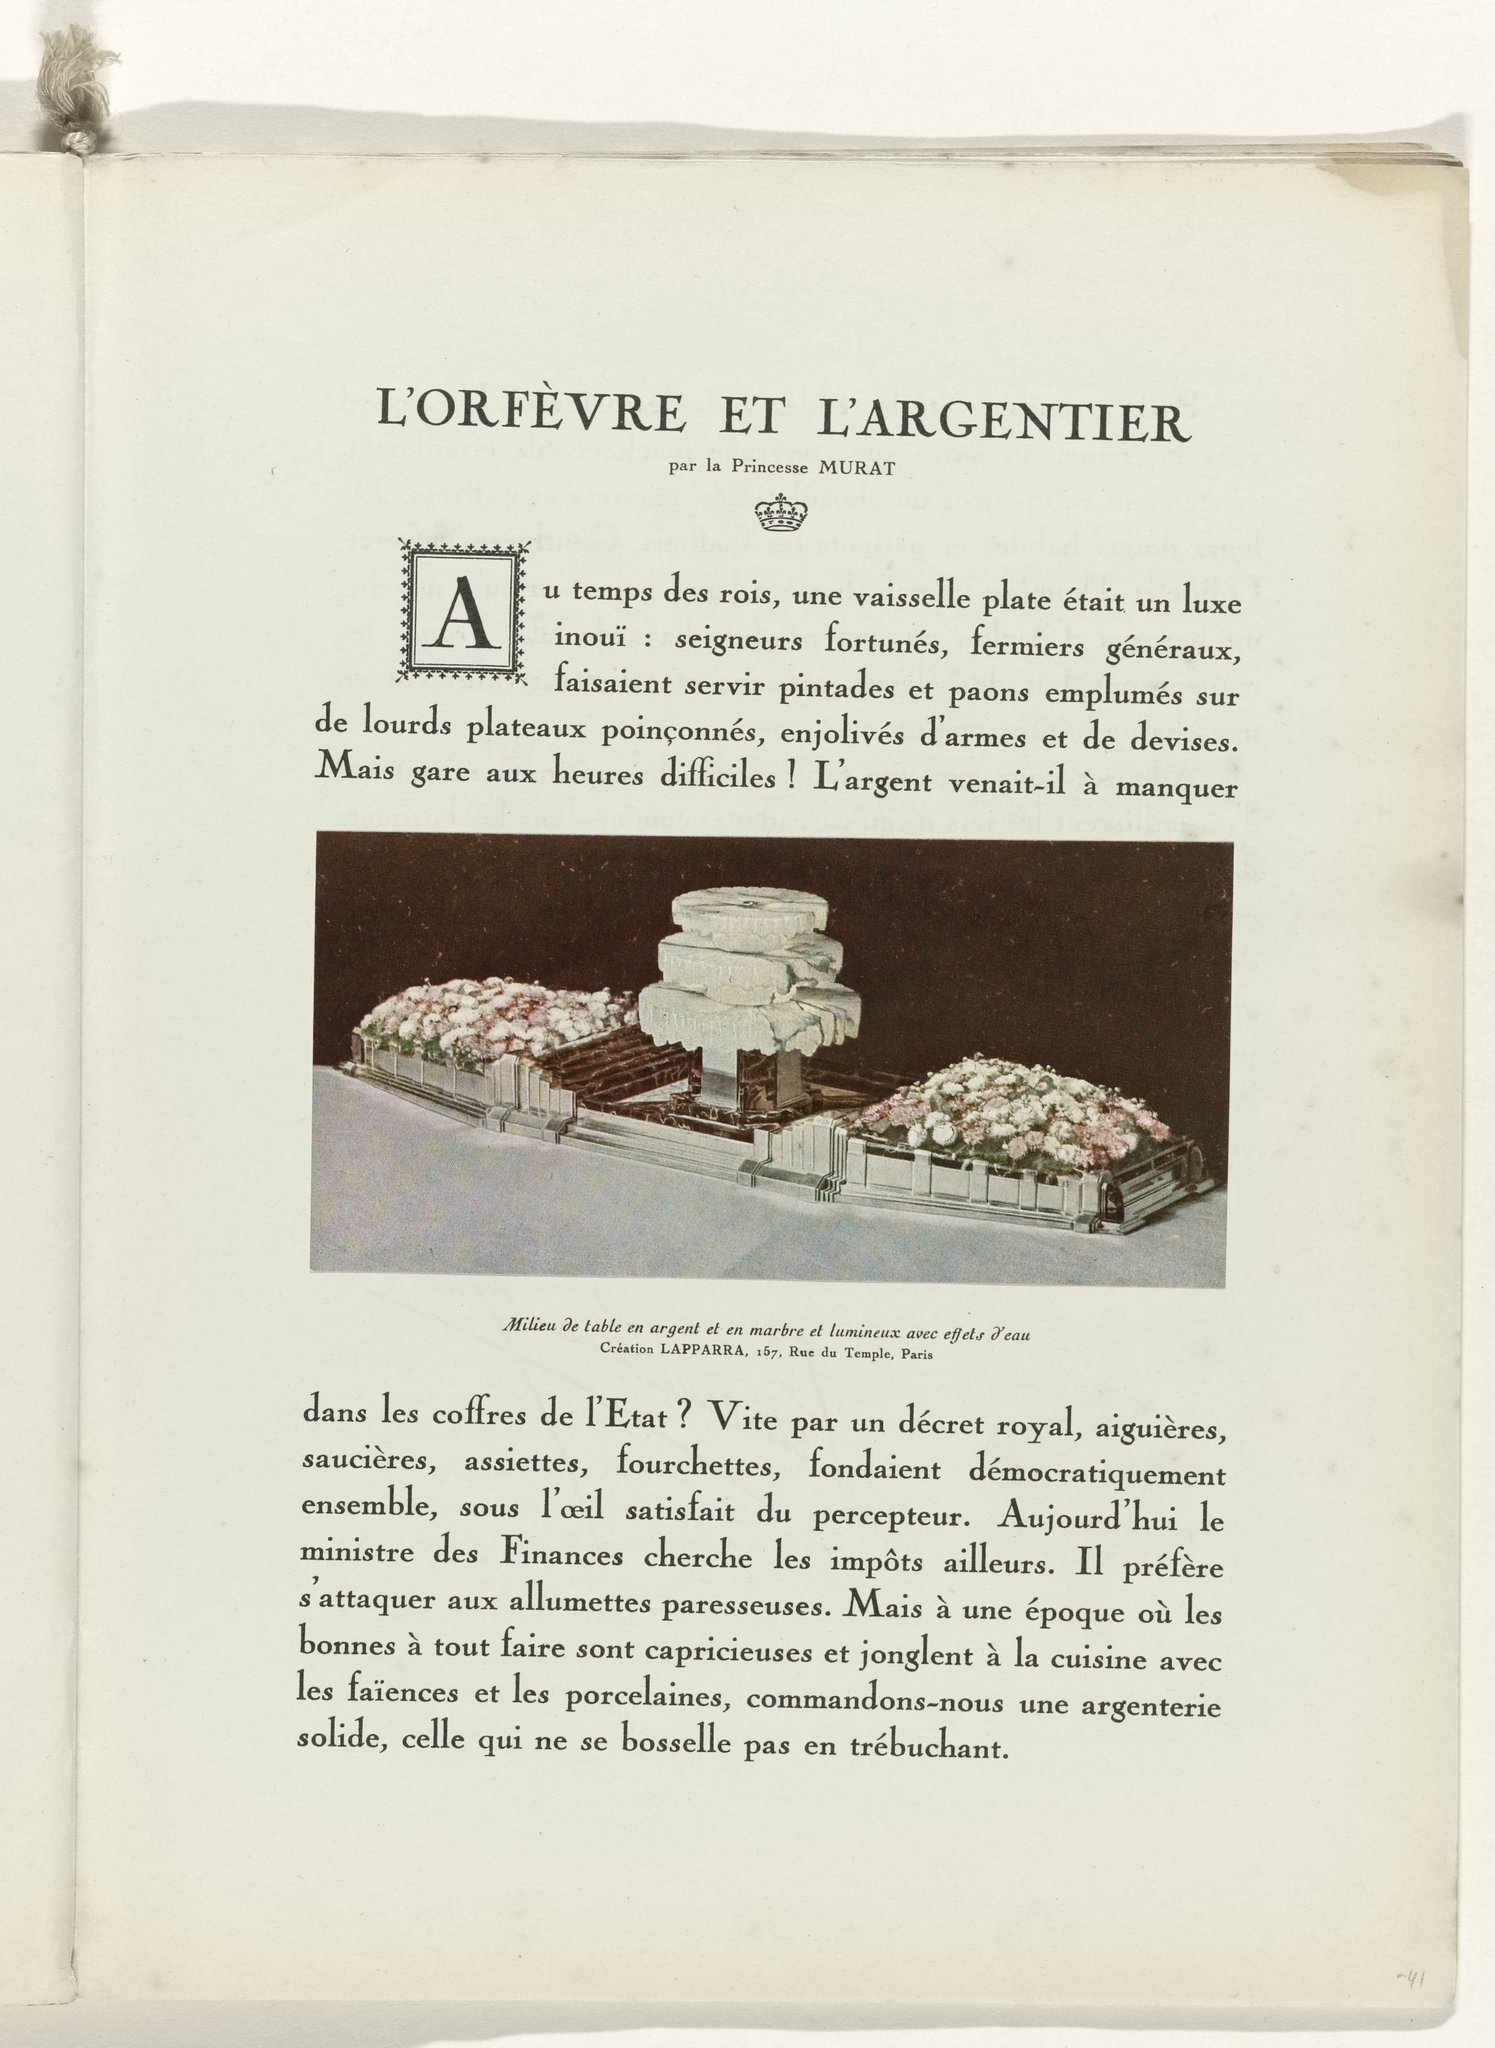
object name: fashion print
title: Art - Goût - Beauté, Feuillets de l' élégance féminine, Noël 1928, No. 100, 9e Année, p. 41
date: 1928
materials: paper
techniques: printing, lithograph, photography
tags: centre-piece, epergne, 'surtout', 'milieu-de-table', fashion plates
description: Tekst 'L'orfévre et l 'argentier' met een afbeelding van een 'milieu de table' (middenstuk) in zilver en marmer, van Lapparra. Pagina uit het modetijdschrift Art-Goût-Beauté (1920-1933).